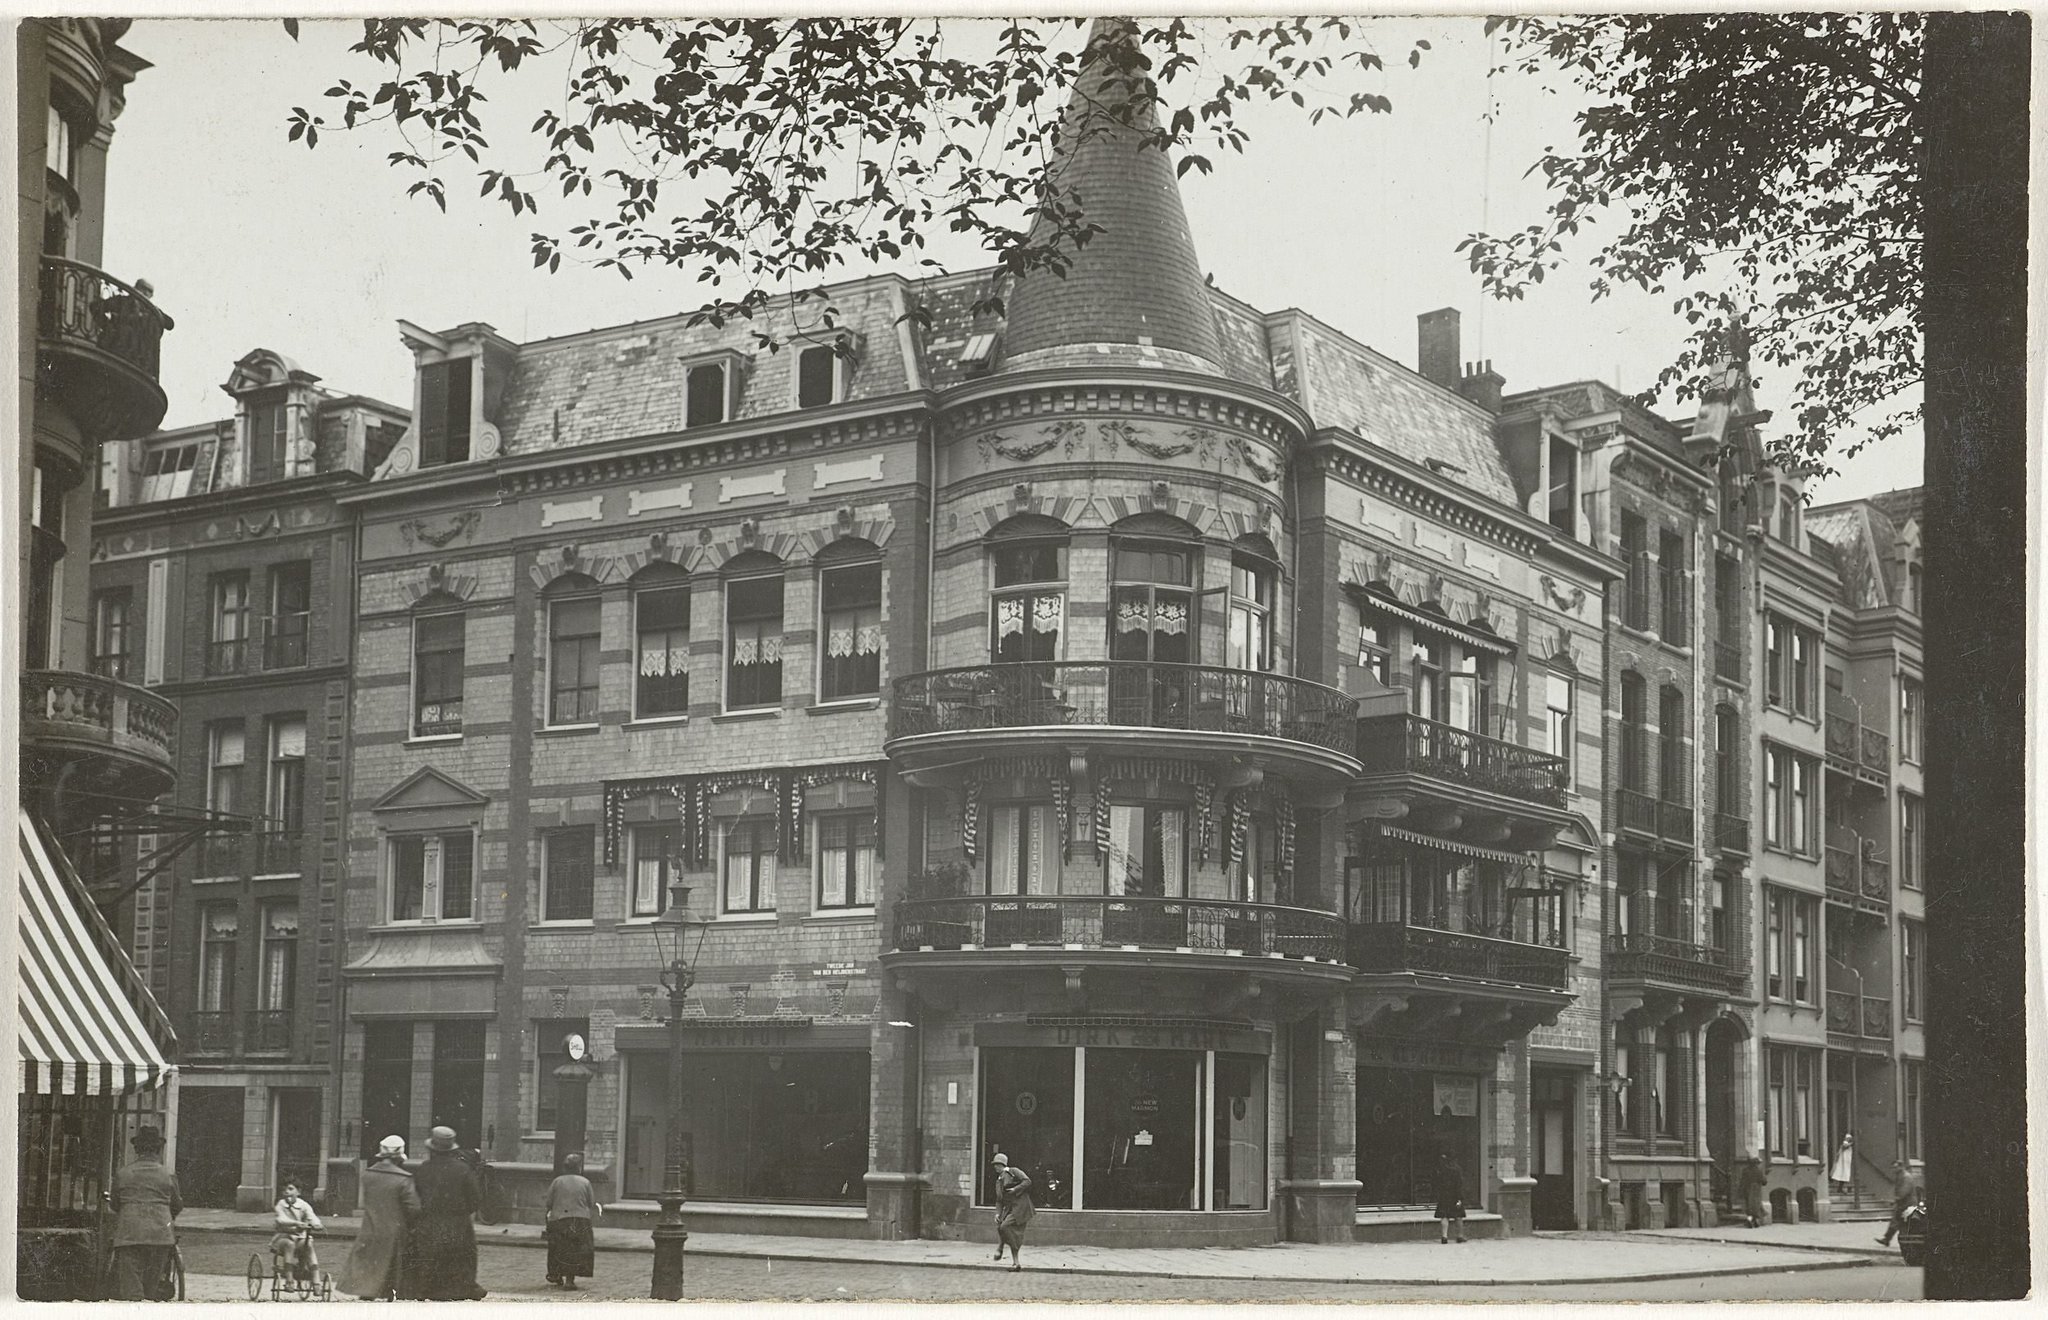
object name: photograph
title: Showroom Dirk van der Mark, Amsteldijk hoek 2e Jan van der Heydenstraat, A'dam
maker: Anonymous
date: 1930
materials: paper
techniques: gelatin silver print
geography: amsterdam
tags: shop, store, amsterdam